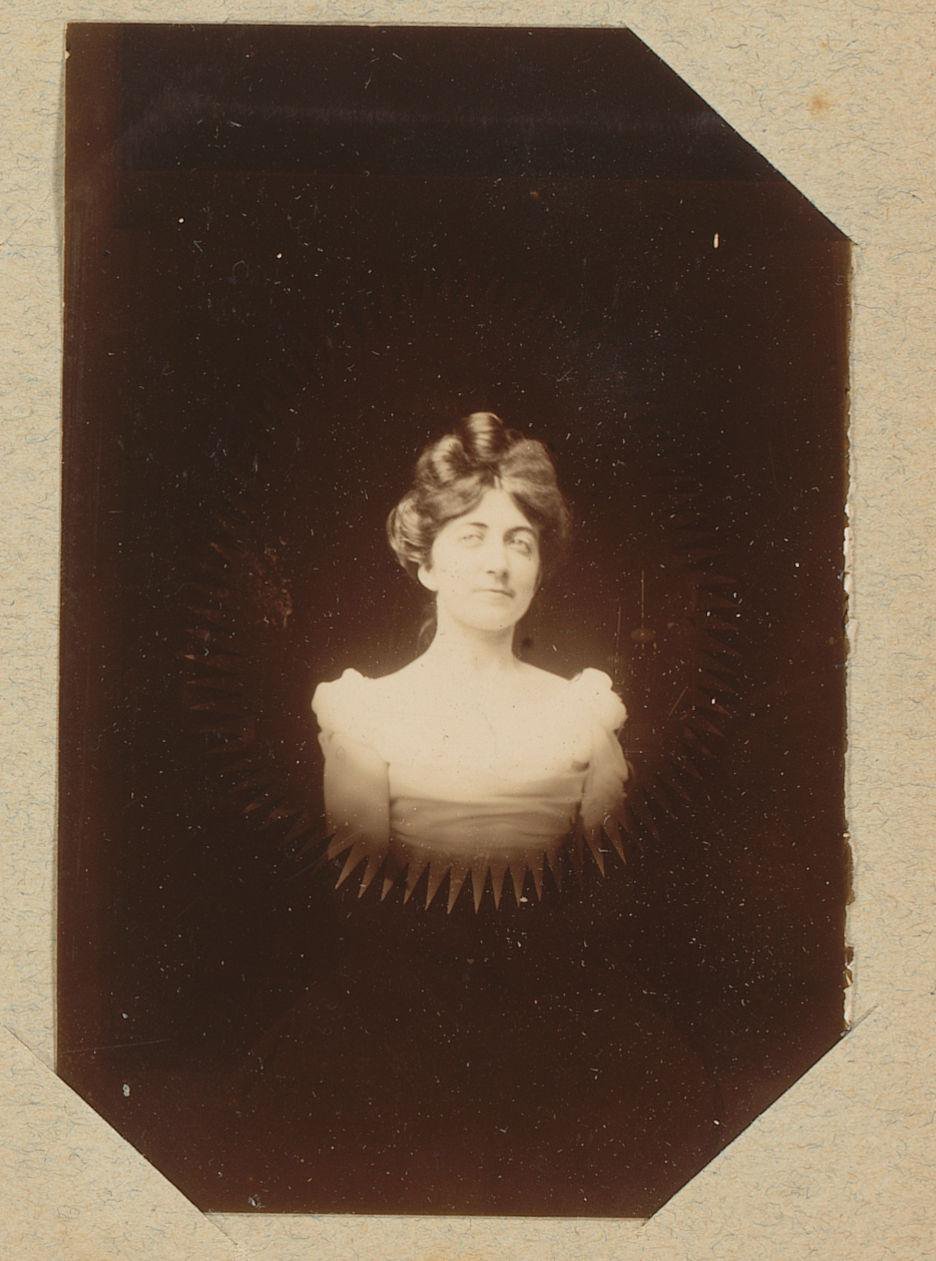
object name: photograph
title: Portret van een jonge vrouw in jurk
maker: Anonymous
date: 1897-1900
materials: paper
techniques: gelatin silver print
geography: france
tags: adolescent, young woman, maiden, historical persons, france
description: Over de foto is een ander negatief afgedrukt van een voorstelling van bomen.